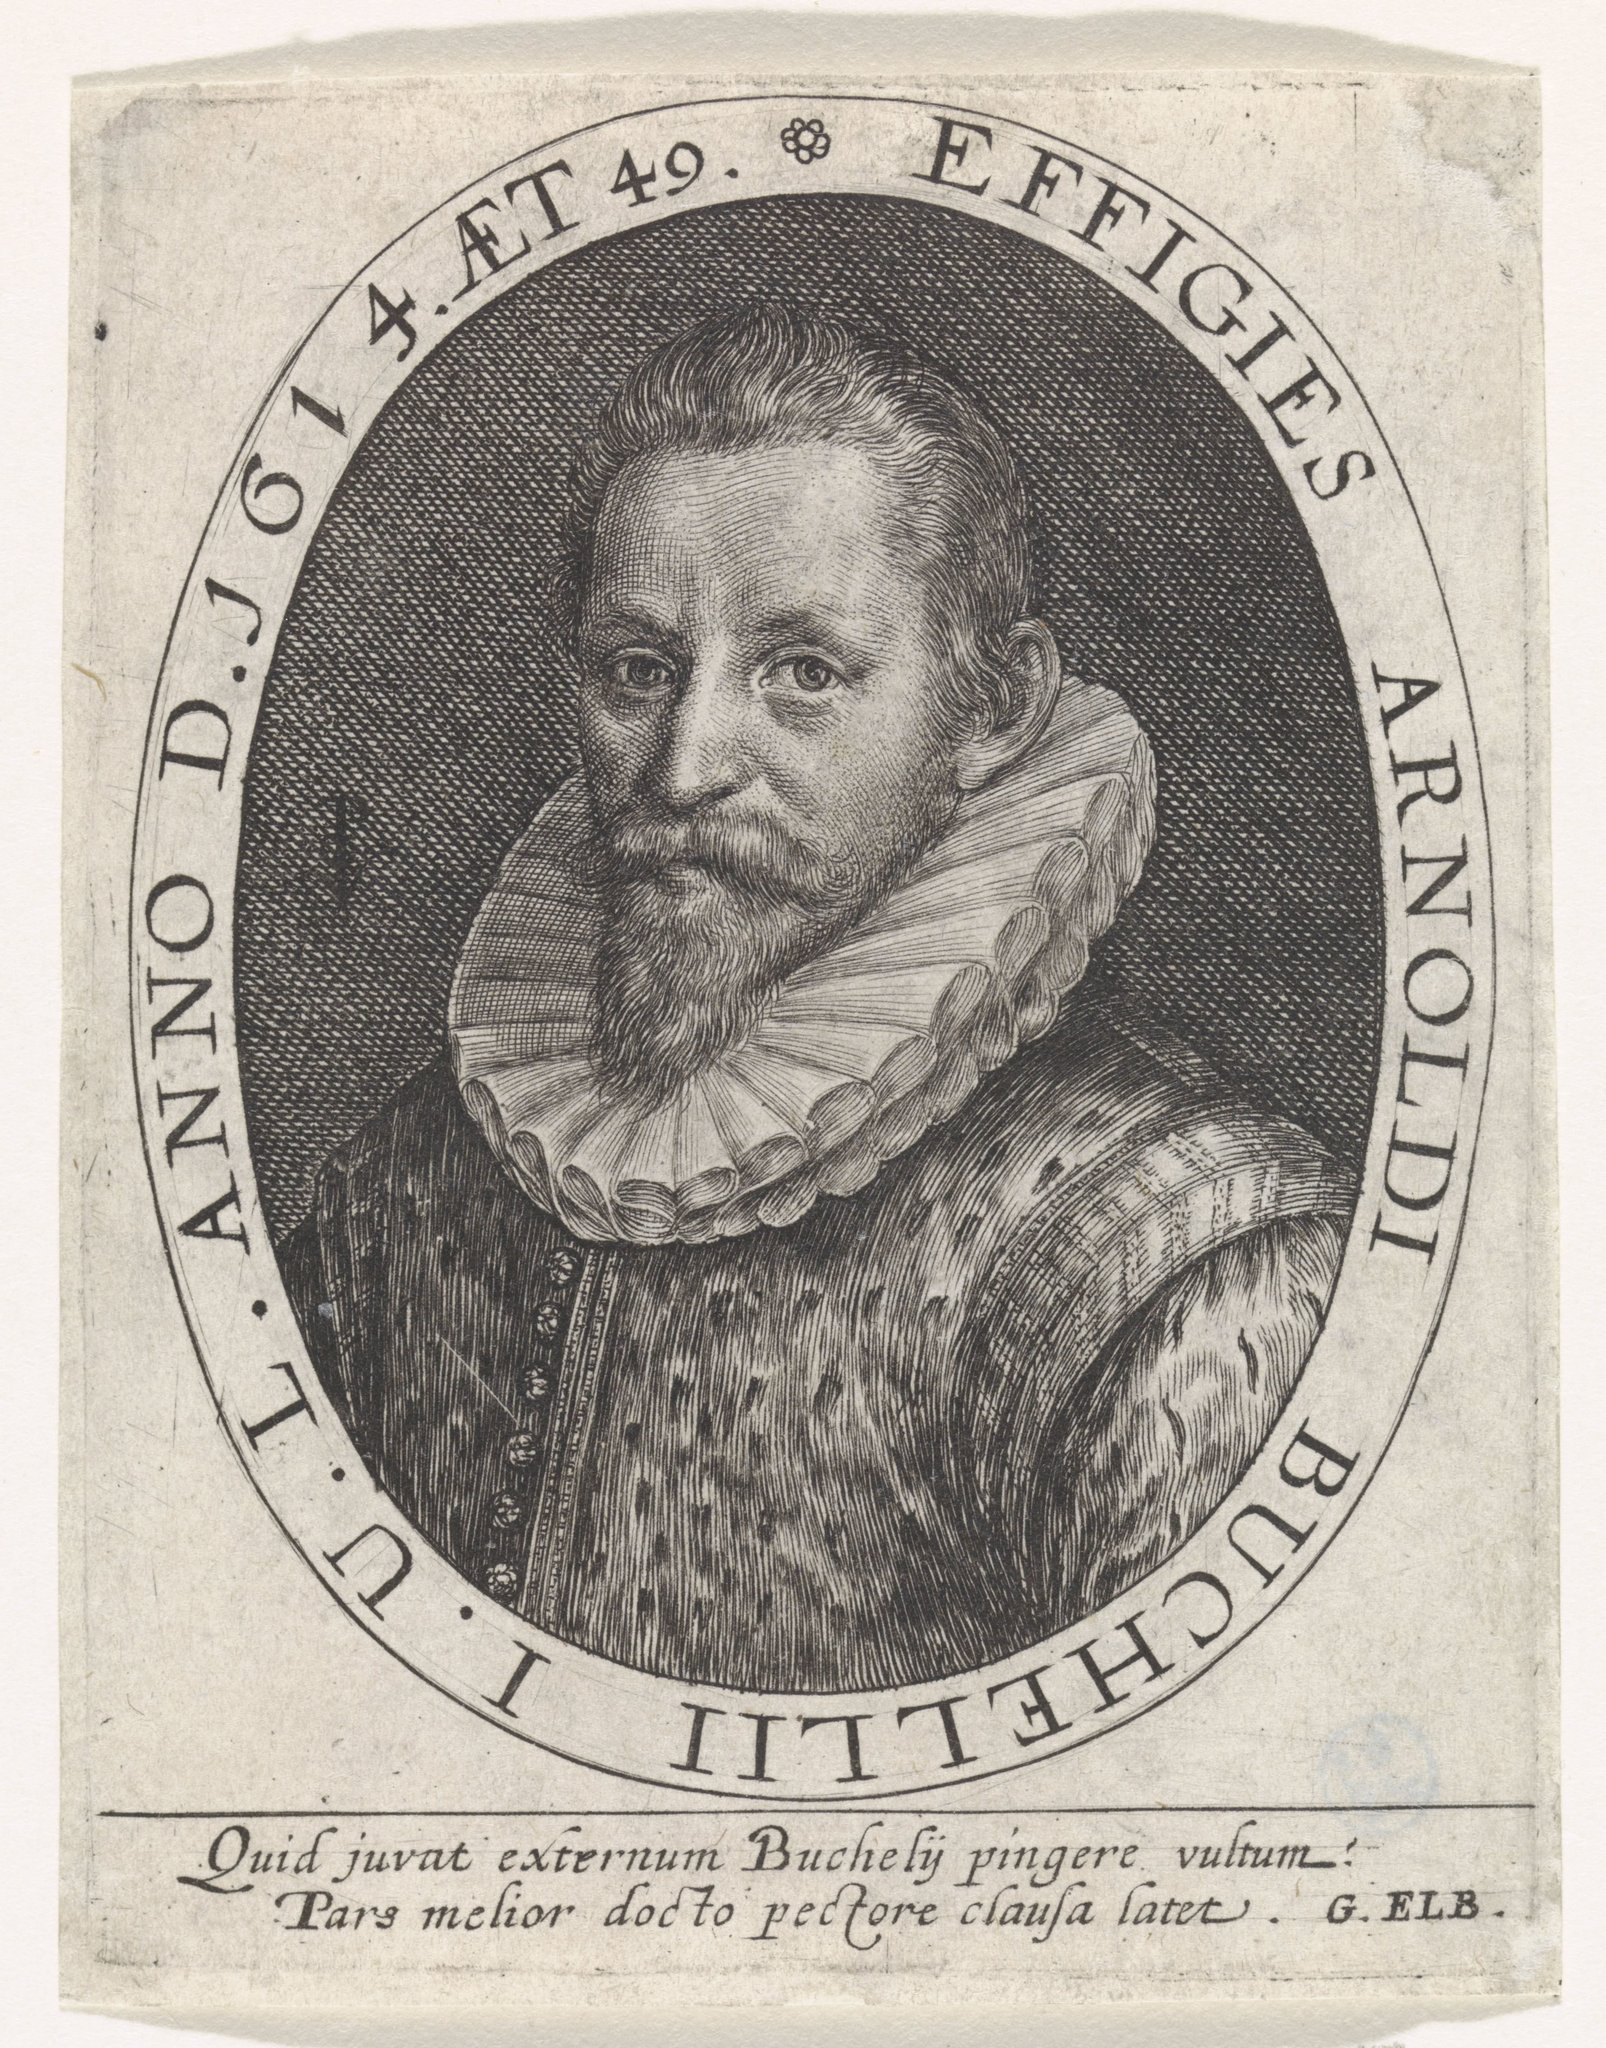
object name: print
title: Portret van Arnold Buchelius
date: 1614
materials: paper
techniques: engraving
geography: utrecht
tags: aernout van buchell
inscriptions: collector's mark: Lugt 1337, collector's mark: Lugt 2228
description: Portret van de schrijver Arnold Buchelius, op 49-jarige leeftijd. In het randschrift van de omlijsting de naam en functie van de geportretteerde in het Latijn. In de marge een tweeregelig onderschrift in het Latijn.